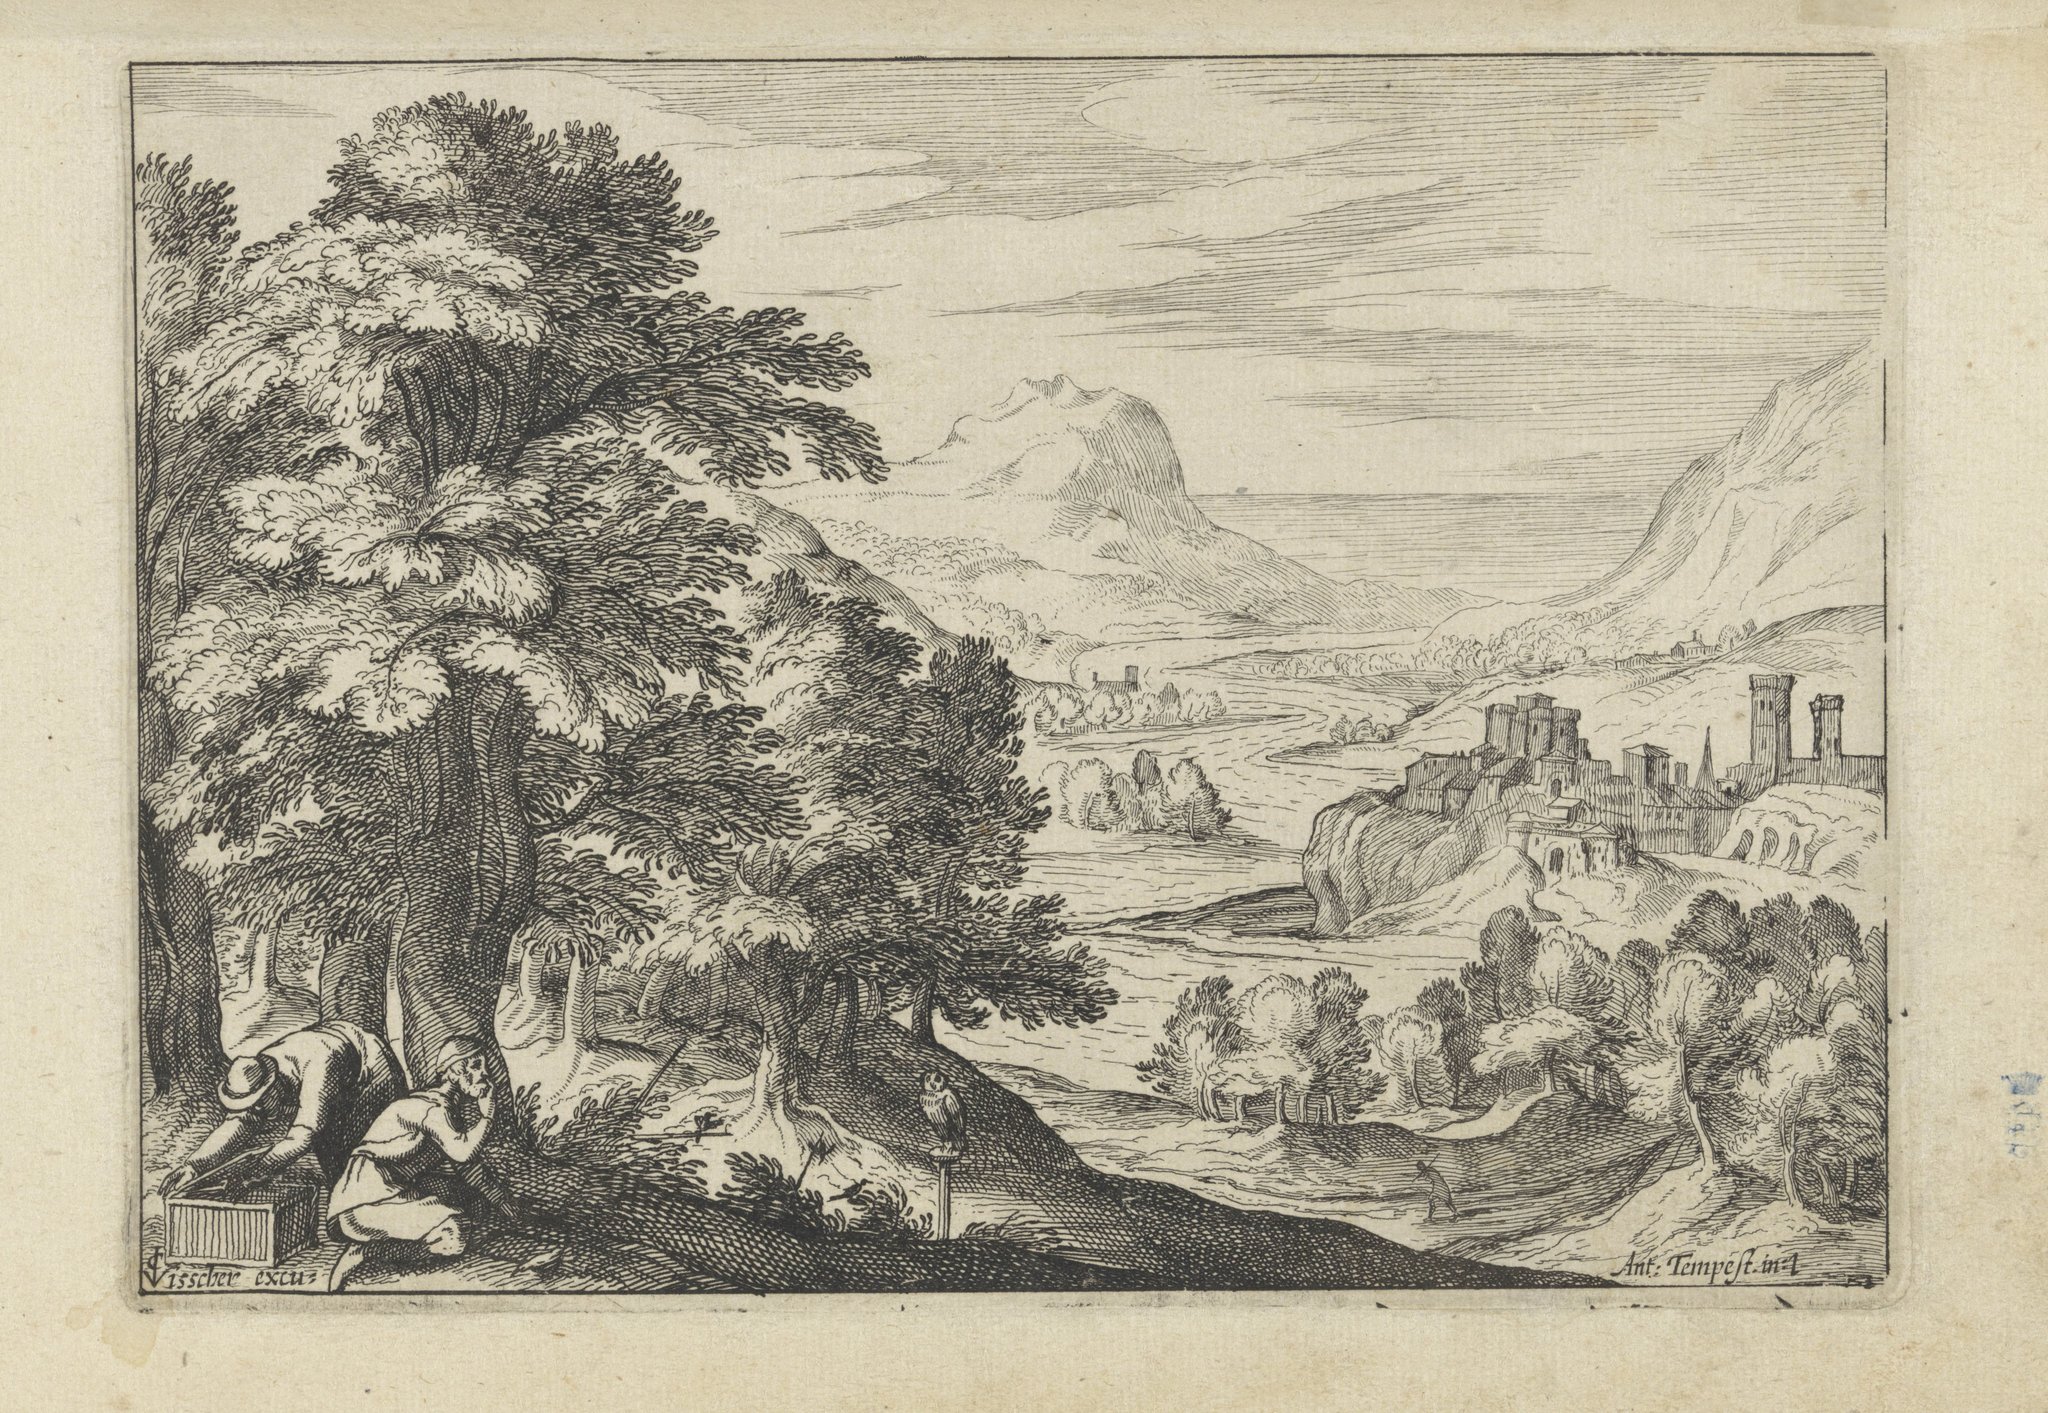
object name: print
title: Landschap met vogelvangers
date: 1612-1652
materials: paper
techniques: engraving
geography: amsterdam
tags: landscapes, bird hunting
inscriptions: address: ‘CJVisscher excu:’, signature: ‘Ant. Tempesta in:’, collector's mark: Lugt 845, collector's mark: Lugt 2228, number: ‘1’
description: Heuvelachtig landschap met links op de voorgrond twee vogelvangers. Een uil zit op een stok als lokaas.